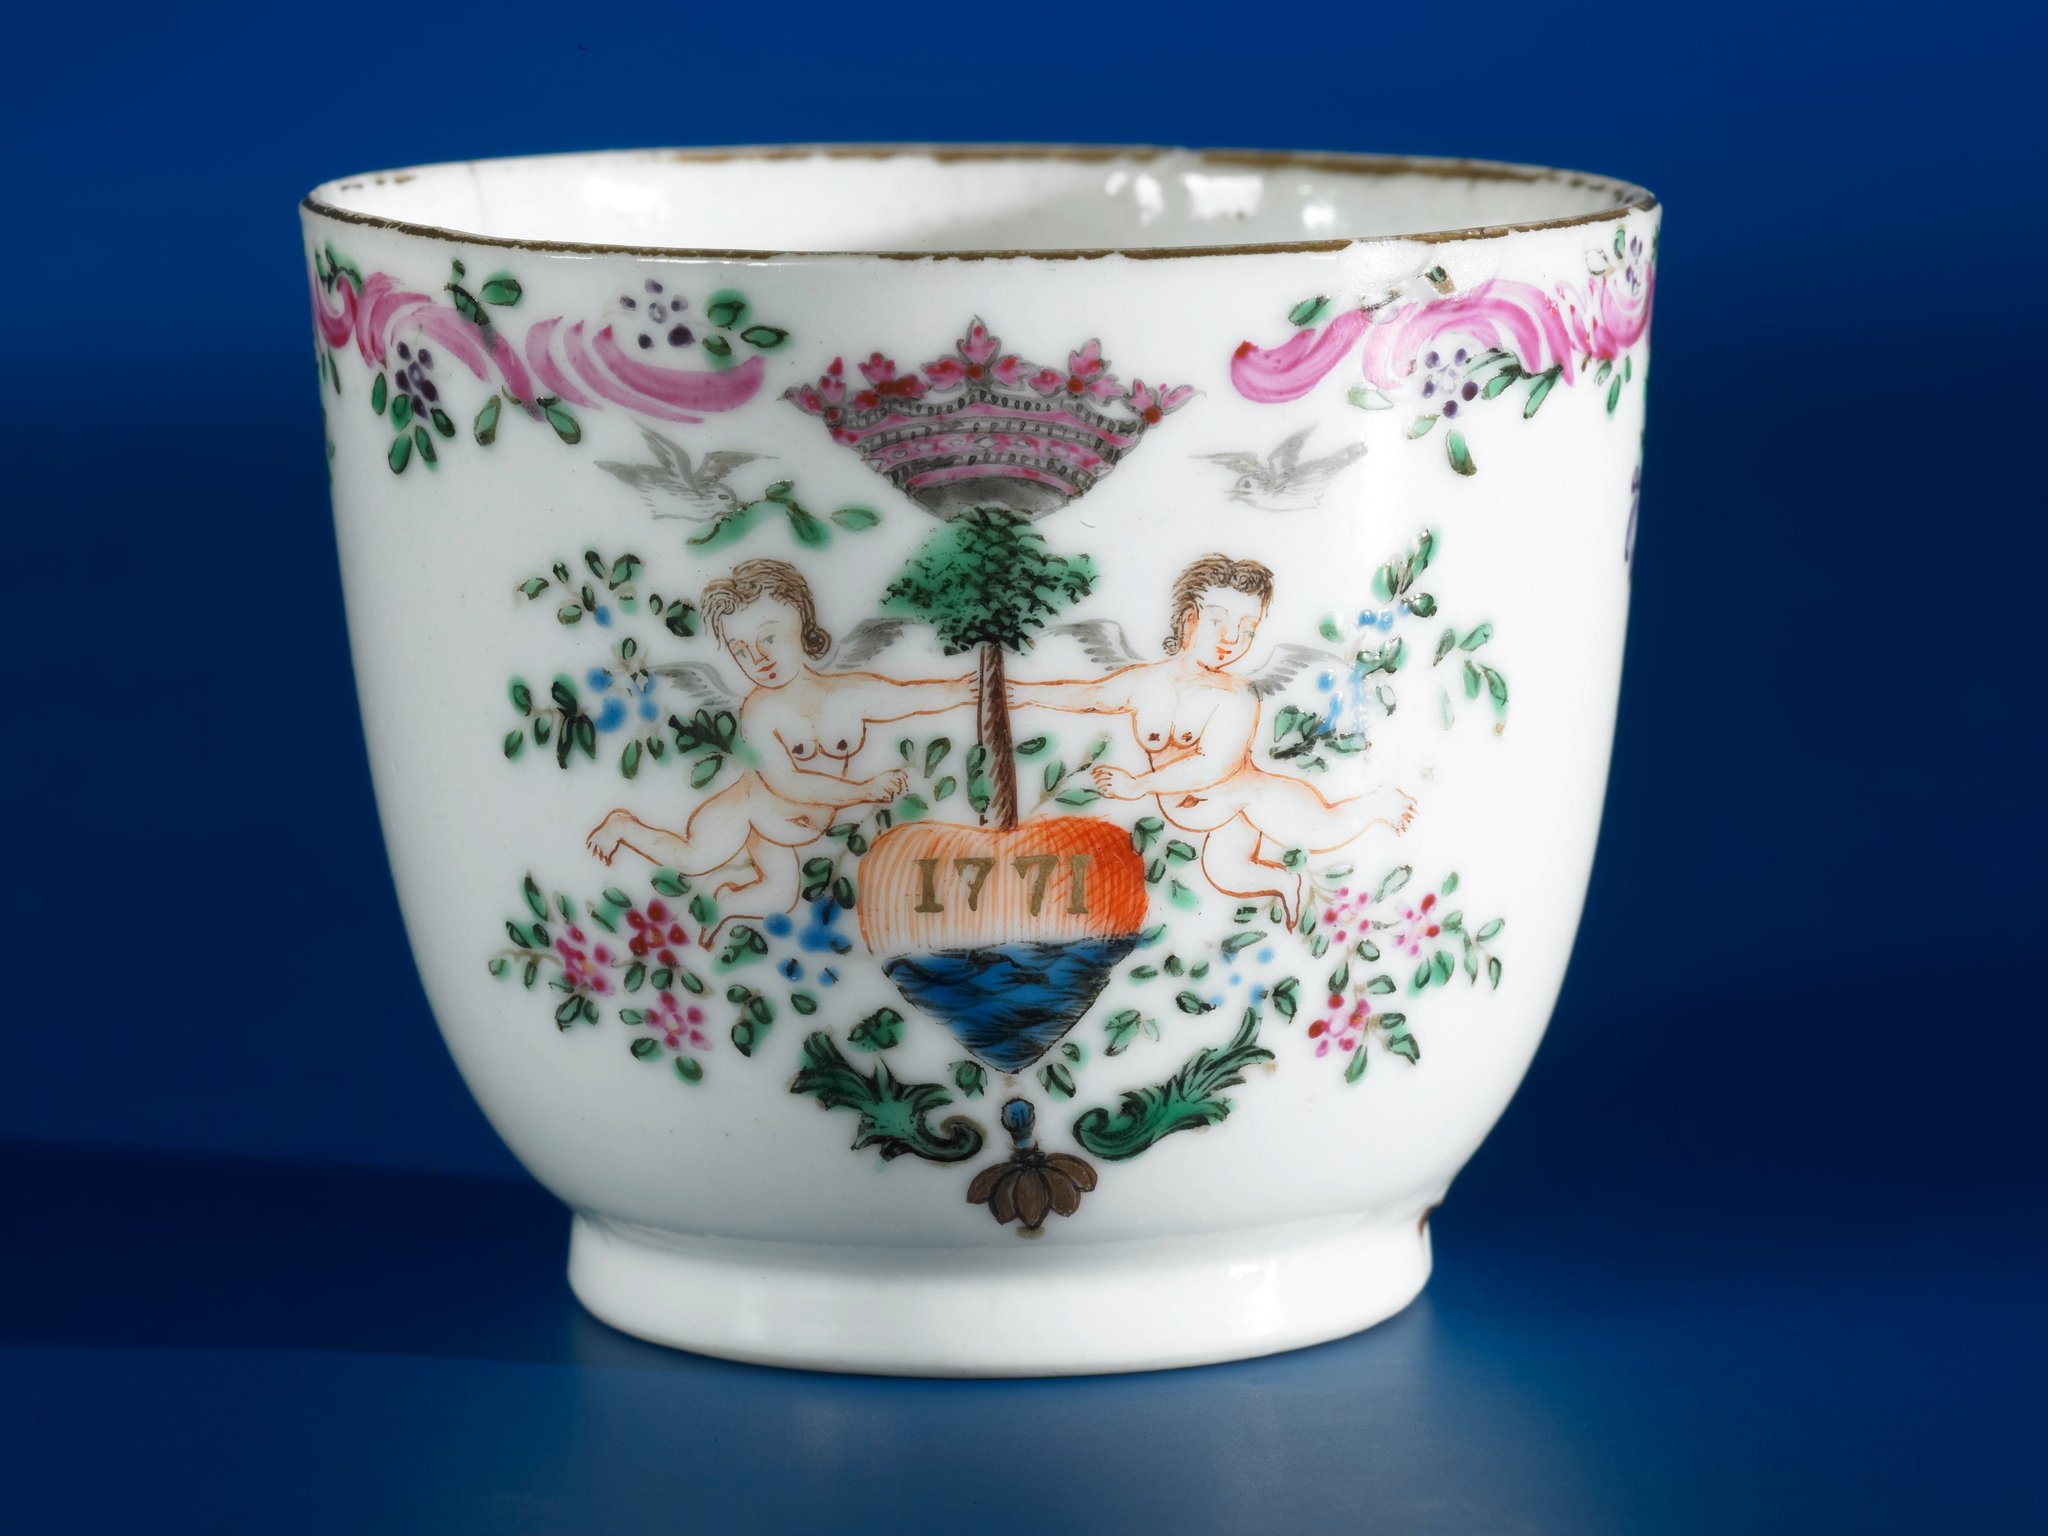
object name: cup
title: Cup with handle with a date in a crowned heart supported by angels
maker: Anonymous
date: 1771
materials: glaze, gold, paint, porcelain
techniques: firing, gilding, turning, vitrification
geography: china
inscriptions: inscription: ‘1771’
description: Oorkop van porselein, beschilderd op het glazuur in blauw, rood, roze, groen, zwart en goud. Op de buitenwand een gekroond hart met de datum '1771'. Het hart wordt vastgehouden door twee engelen en omvat door bloemtakken en bladranken. Naast de kroon twee vogels. Op de buitenrand een band met bloemranken. Een barst in de wand. Europese voorstelling in emailkleuren.